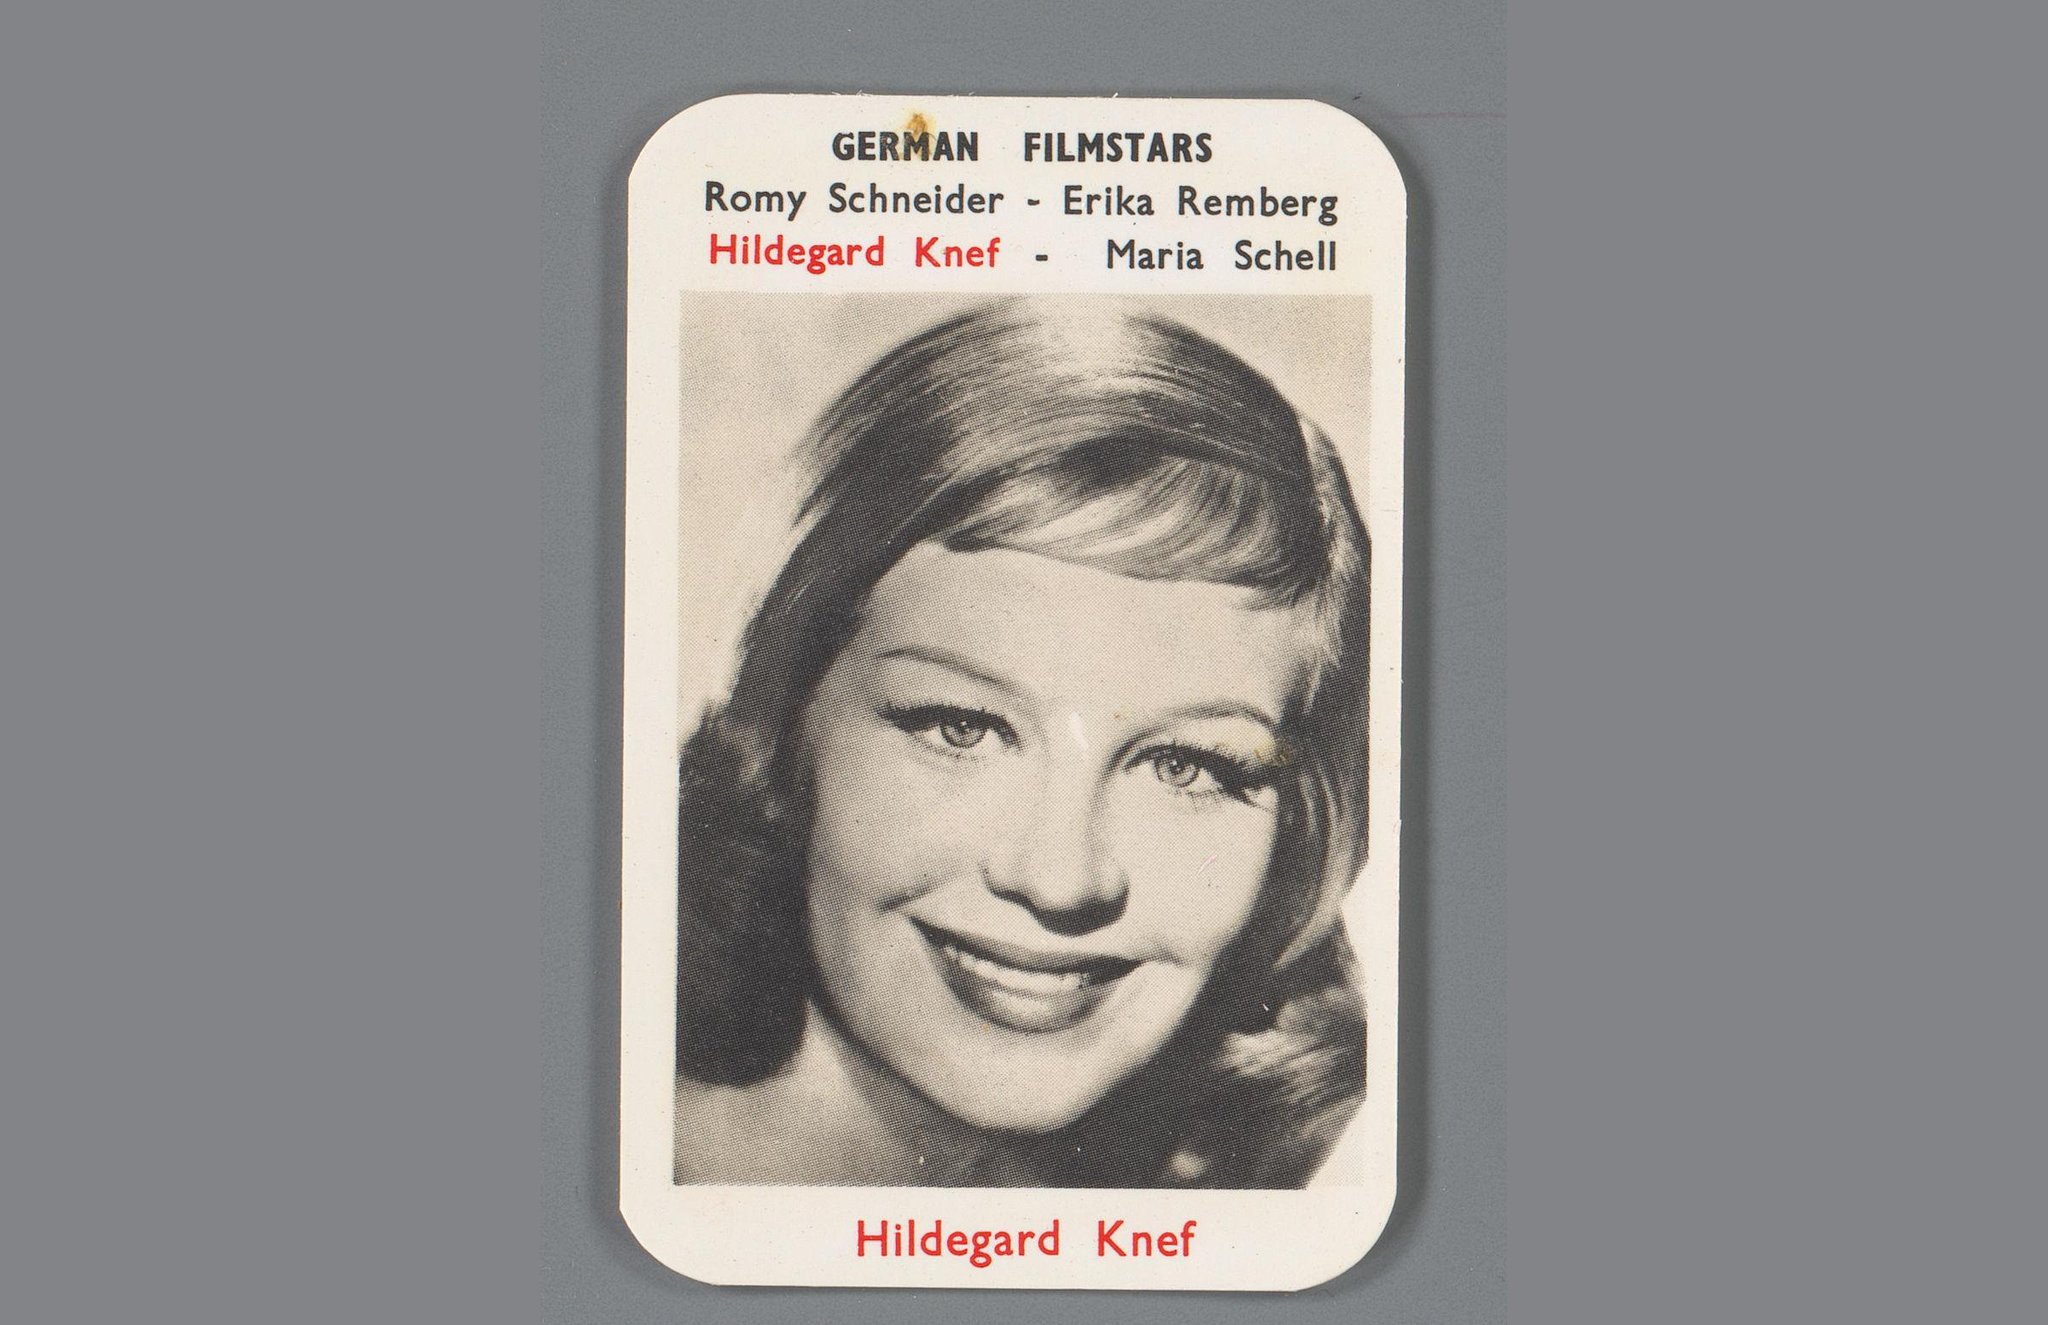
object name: photomechanical print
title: German Filmstars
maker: Anonymous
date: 1960-1970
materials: paper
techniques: autotype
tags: portrait of actor, actress